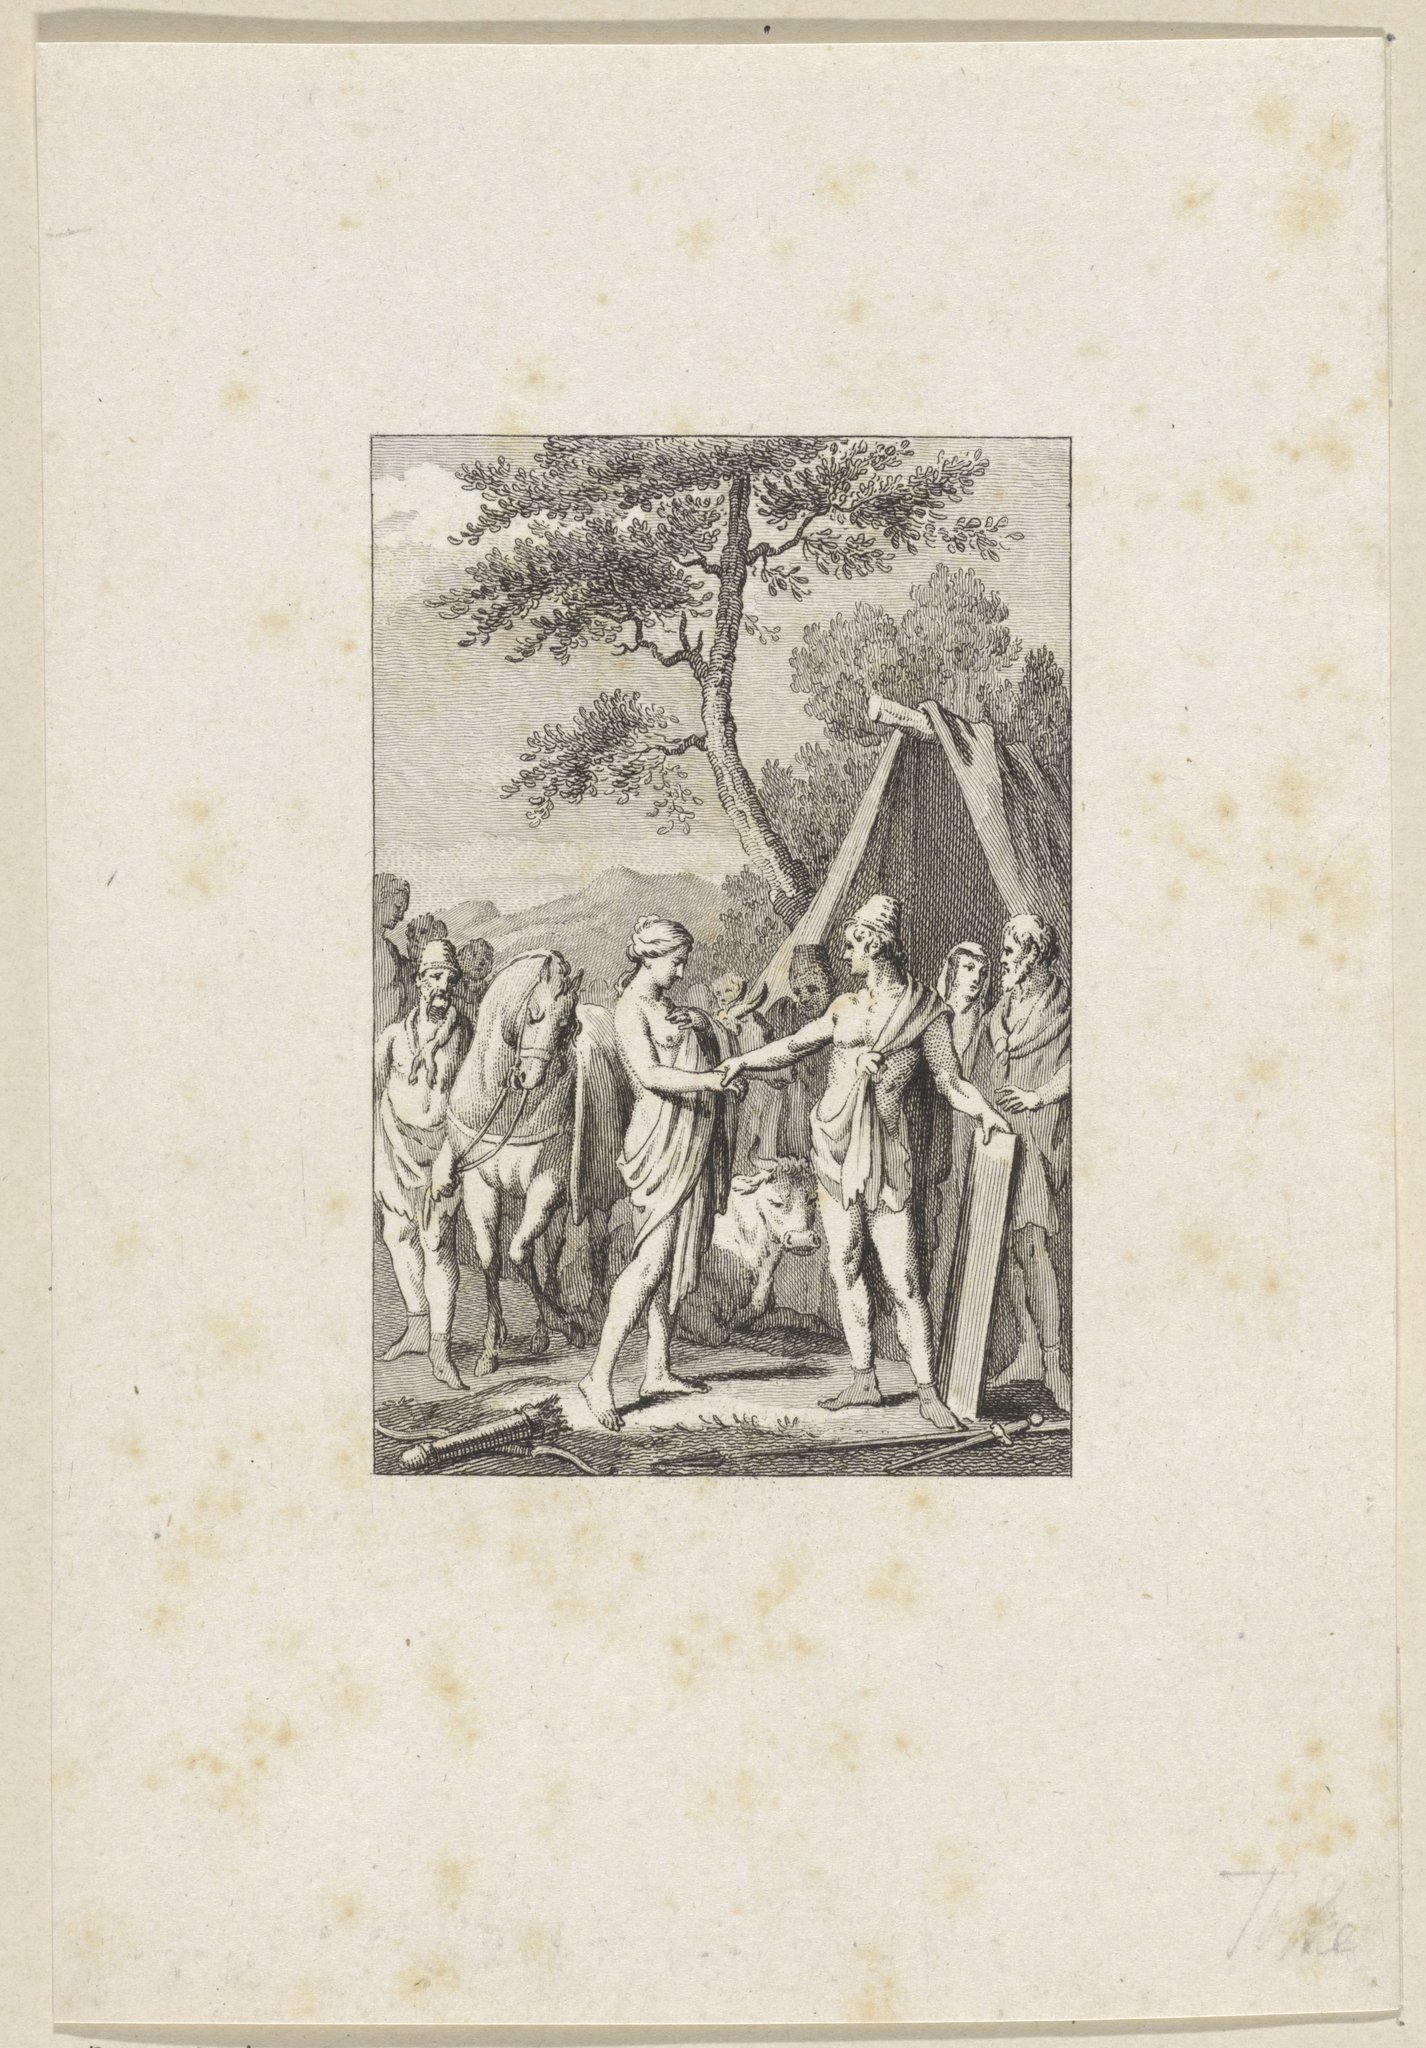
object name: print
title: Huwelijksvoltrekking bij de Batavieren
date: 1783-1795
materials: paper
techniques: etching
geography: amsterdam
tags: civil marriage ceremony (+ variant), extinct, 'historical' peoples (with name)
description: Illustratie voor: J. Fokke. Geschiedenissen der Vereenigde Nederlanden voor de vaderlandsche jeugd. Amsterdam: Johannes Allart, 1783-1795, 25 delen, dl. I, pl. VI.